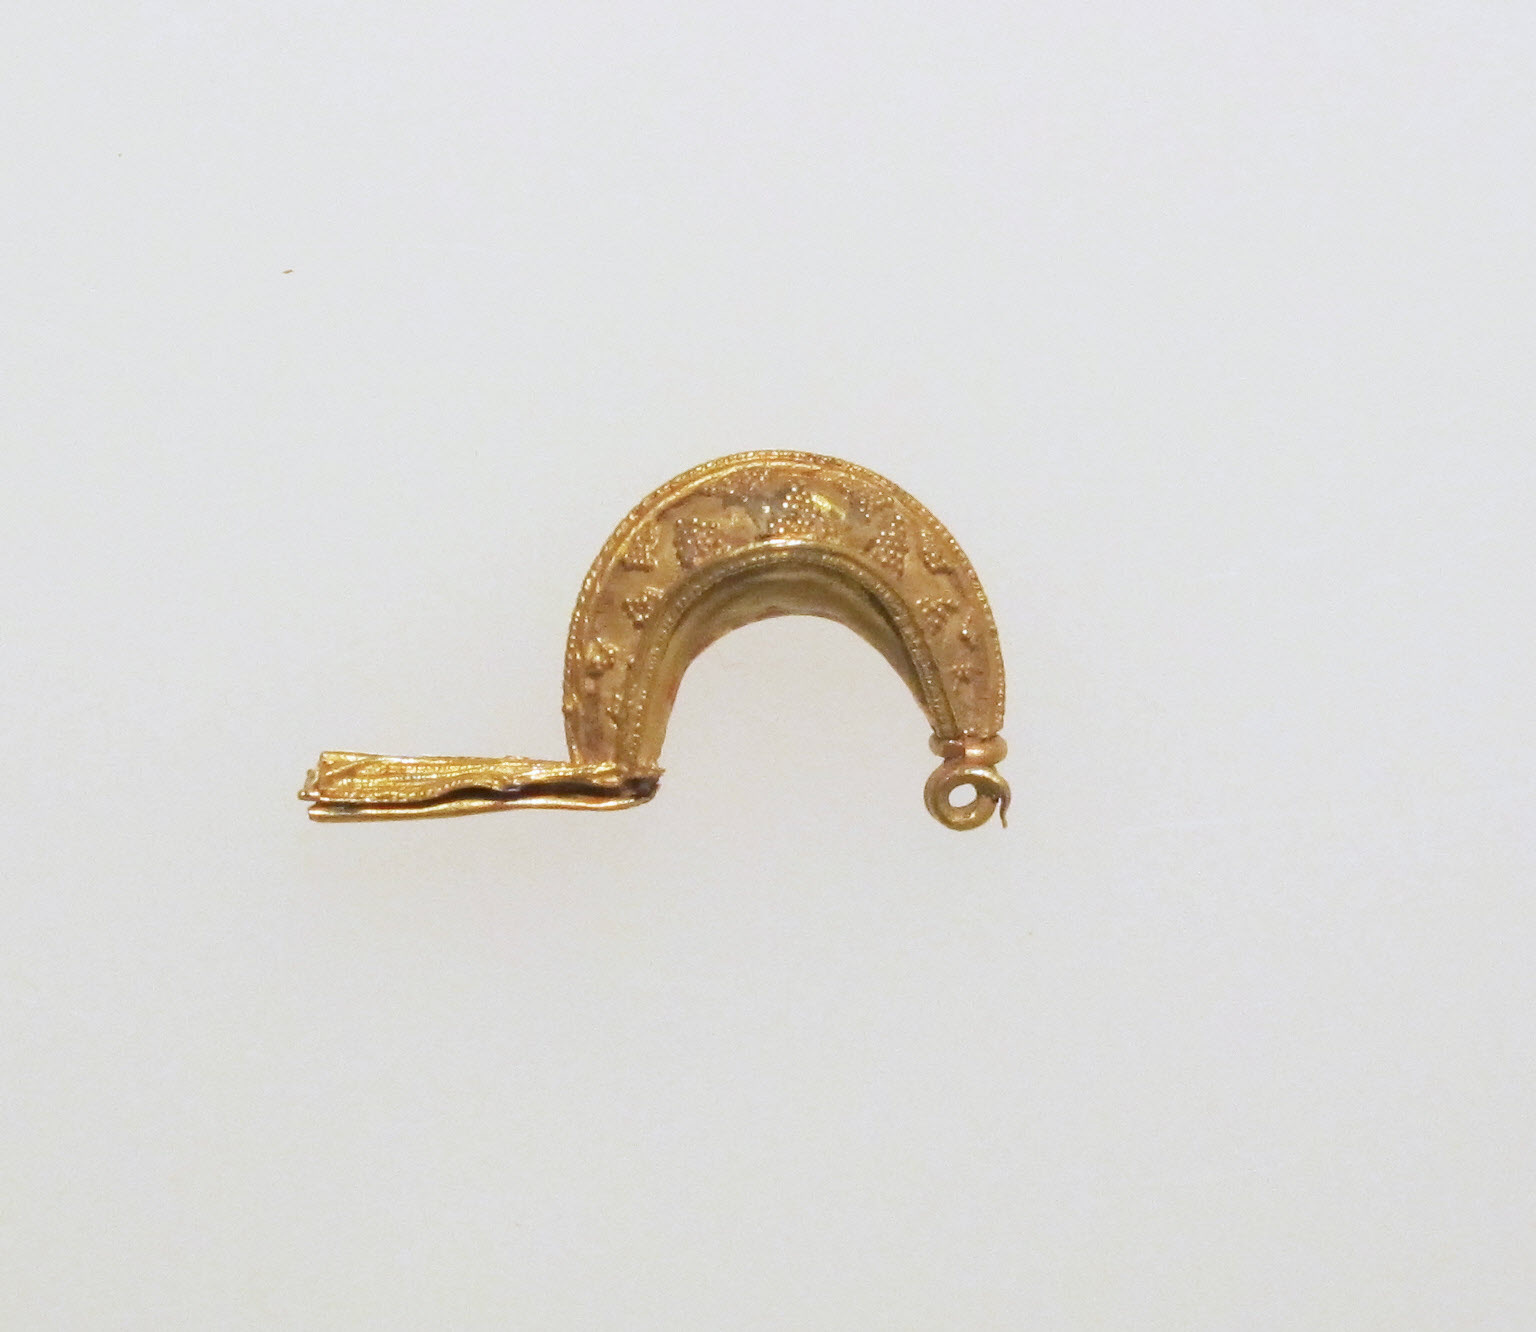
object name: fibula, bow shaped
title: Fibula, bow-shaped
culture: italic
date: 900-100 BCE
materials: gold